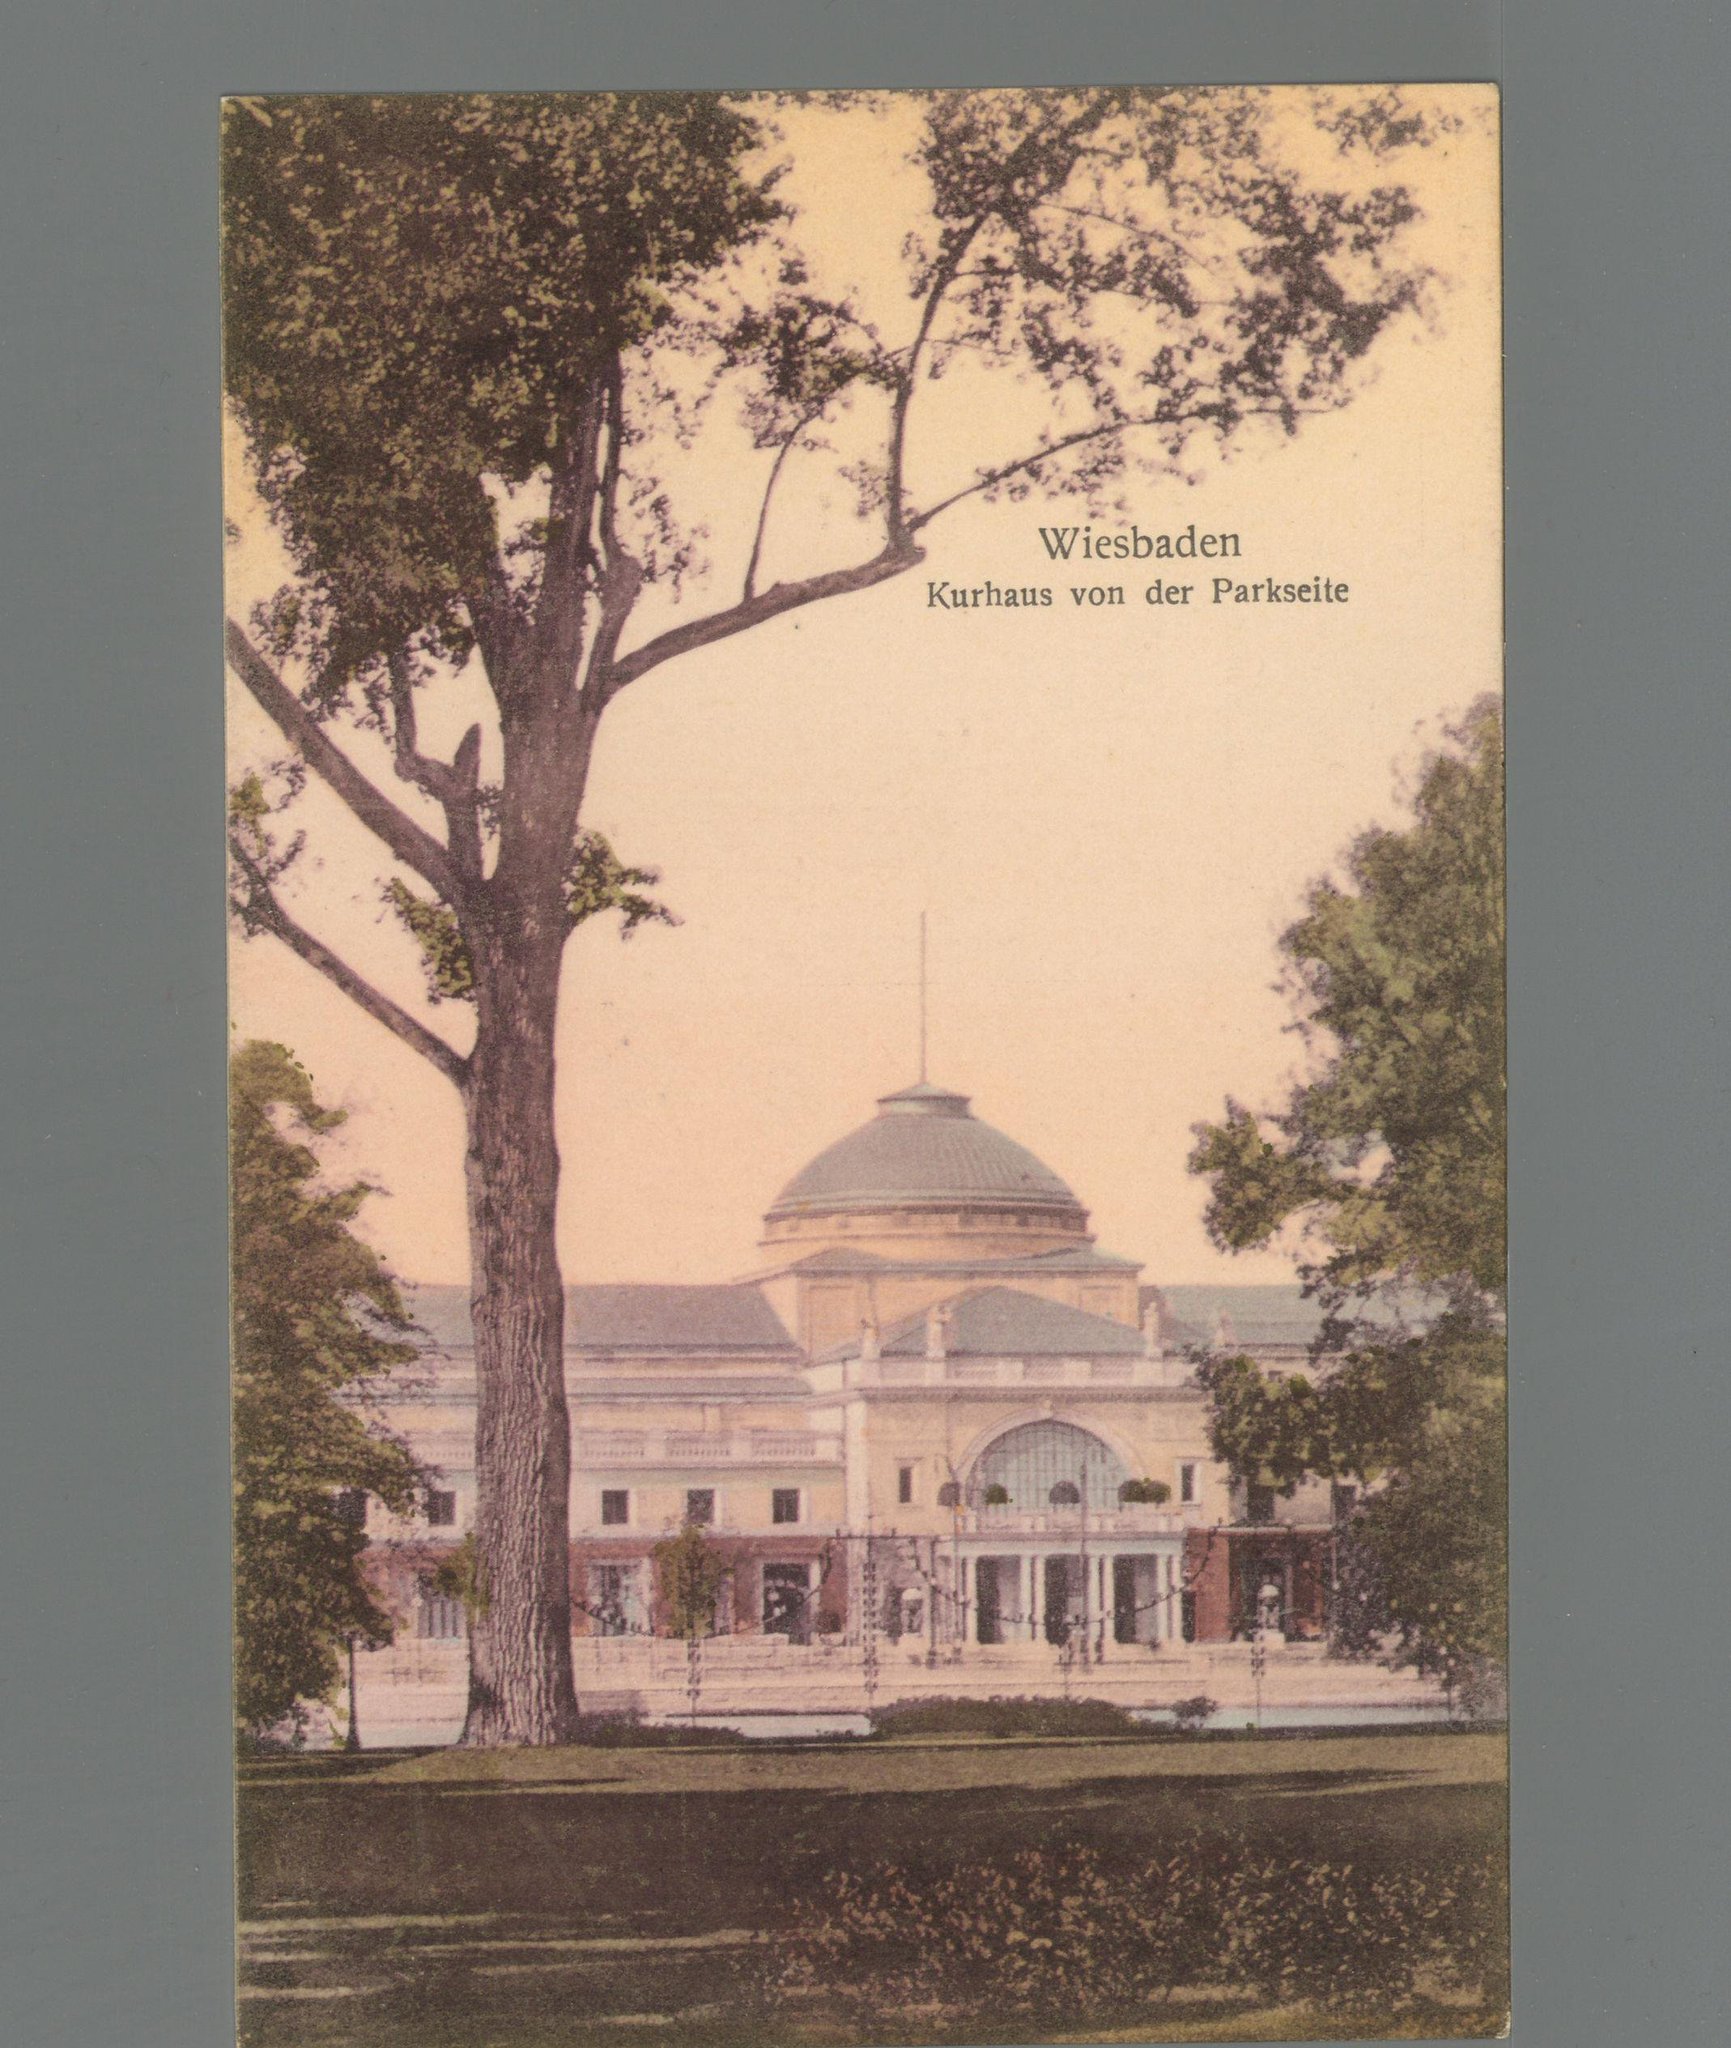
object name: photomechanical print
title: Wiesbaden. Kurhaus von der Parkseite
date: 1908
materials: cardboard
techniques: photograph, lithograph, writing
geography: wiesbaden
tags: watering-place, spa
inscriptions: date